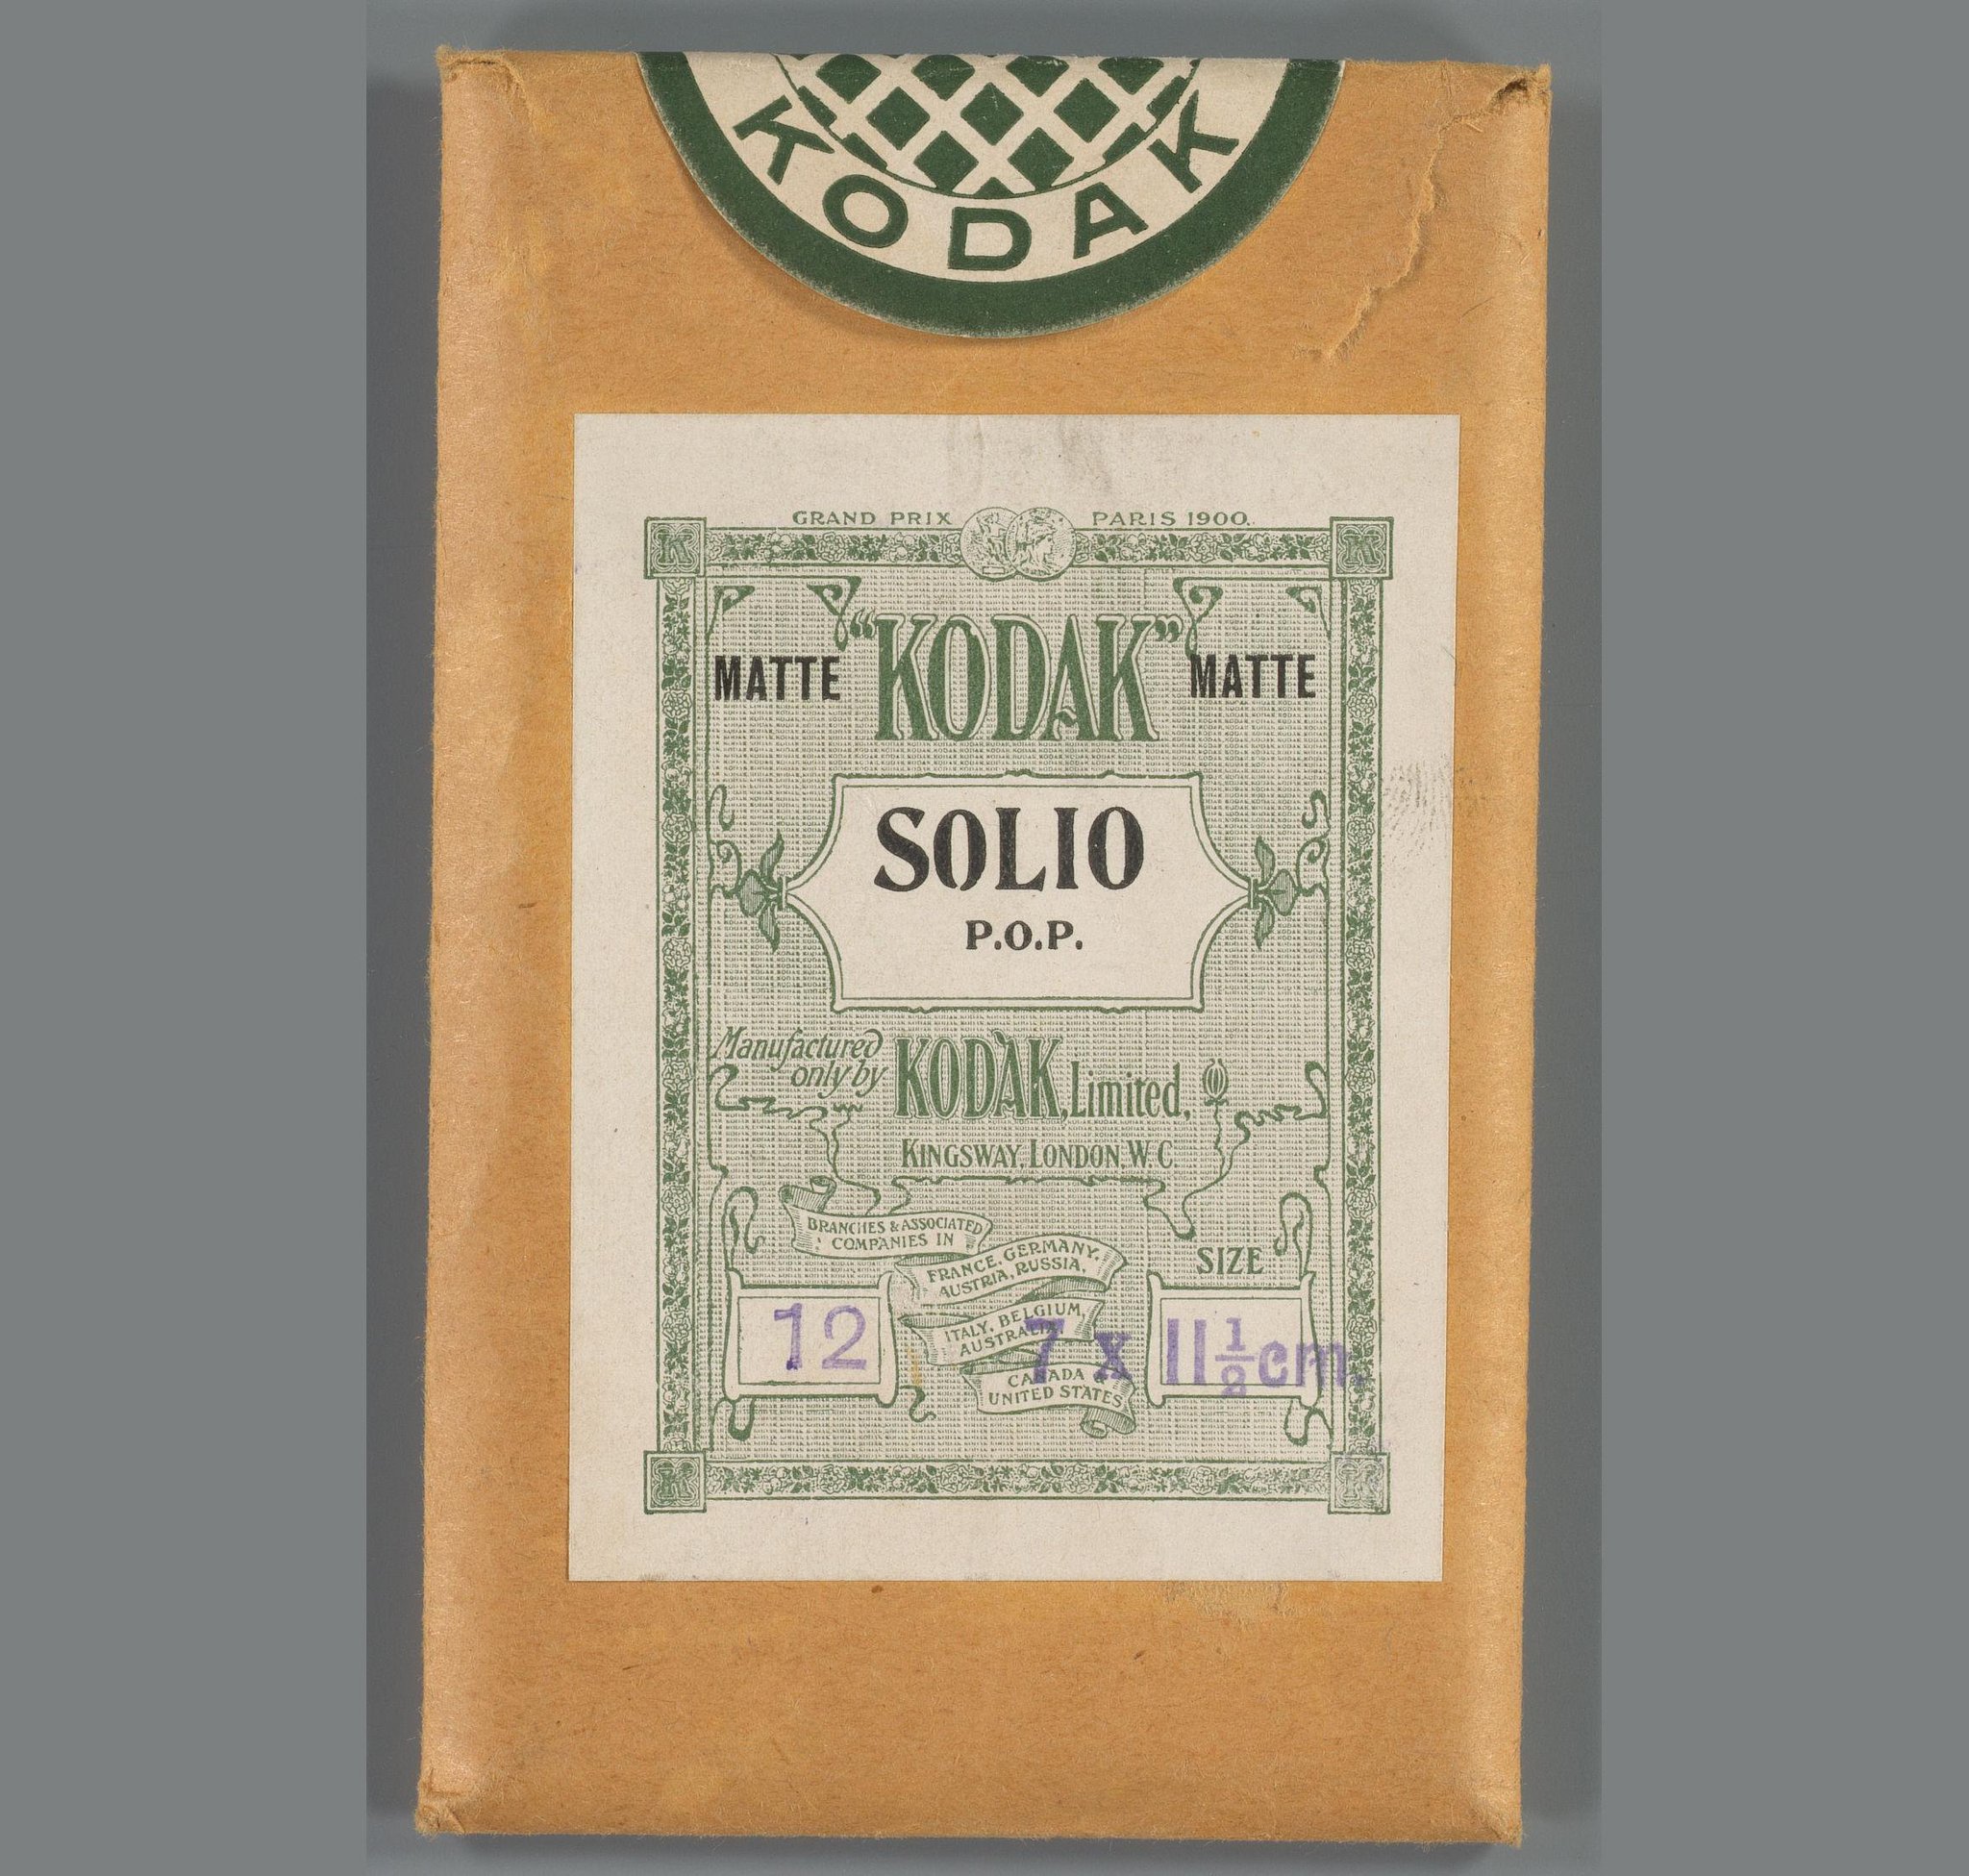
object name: envelope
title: Matte Kodak Solio P.O.P.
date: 1888-1910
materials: paper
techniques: printing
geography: london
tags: letter, envelope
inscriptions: stamp: ‘EMULSION-PACKED BY/ 3399-18-24/ 2212’